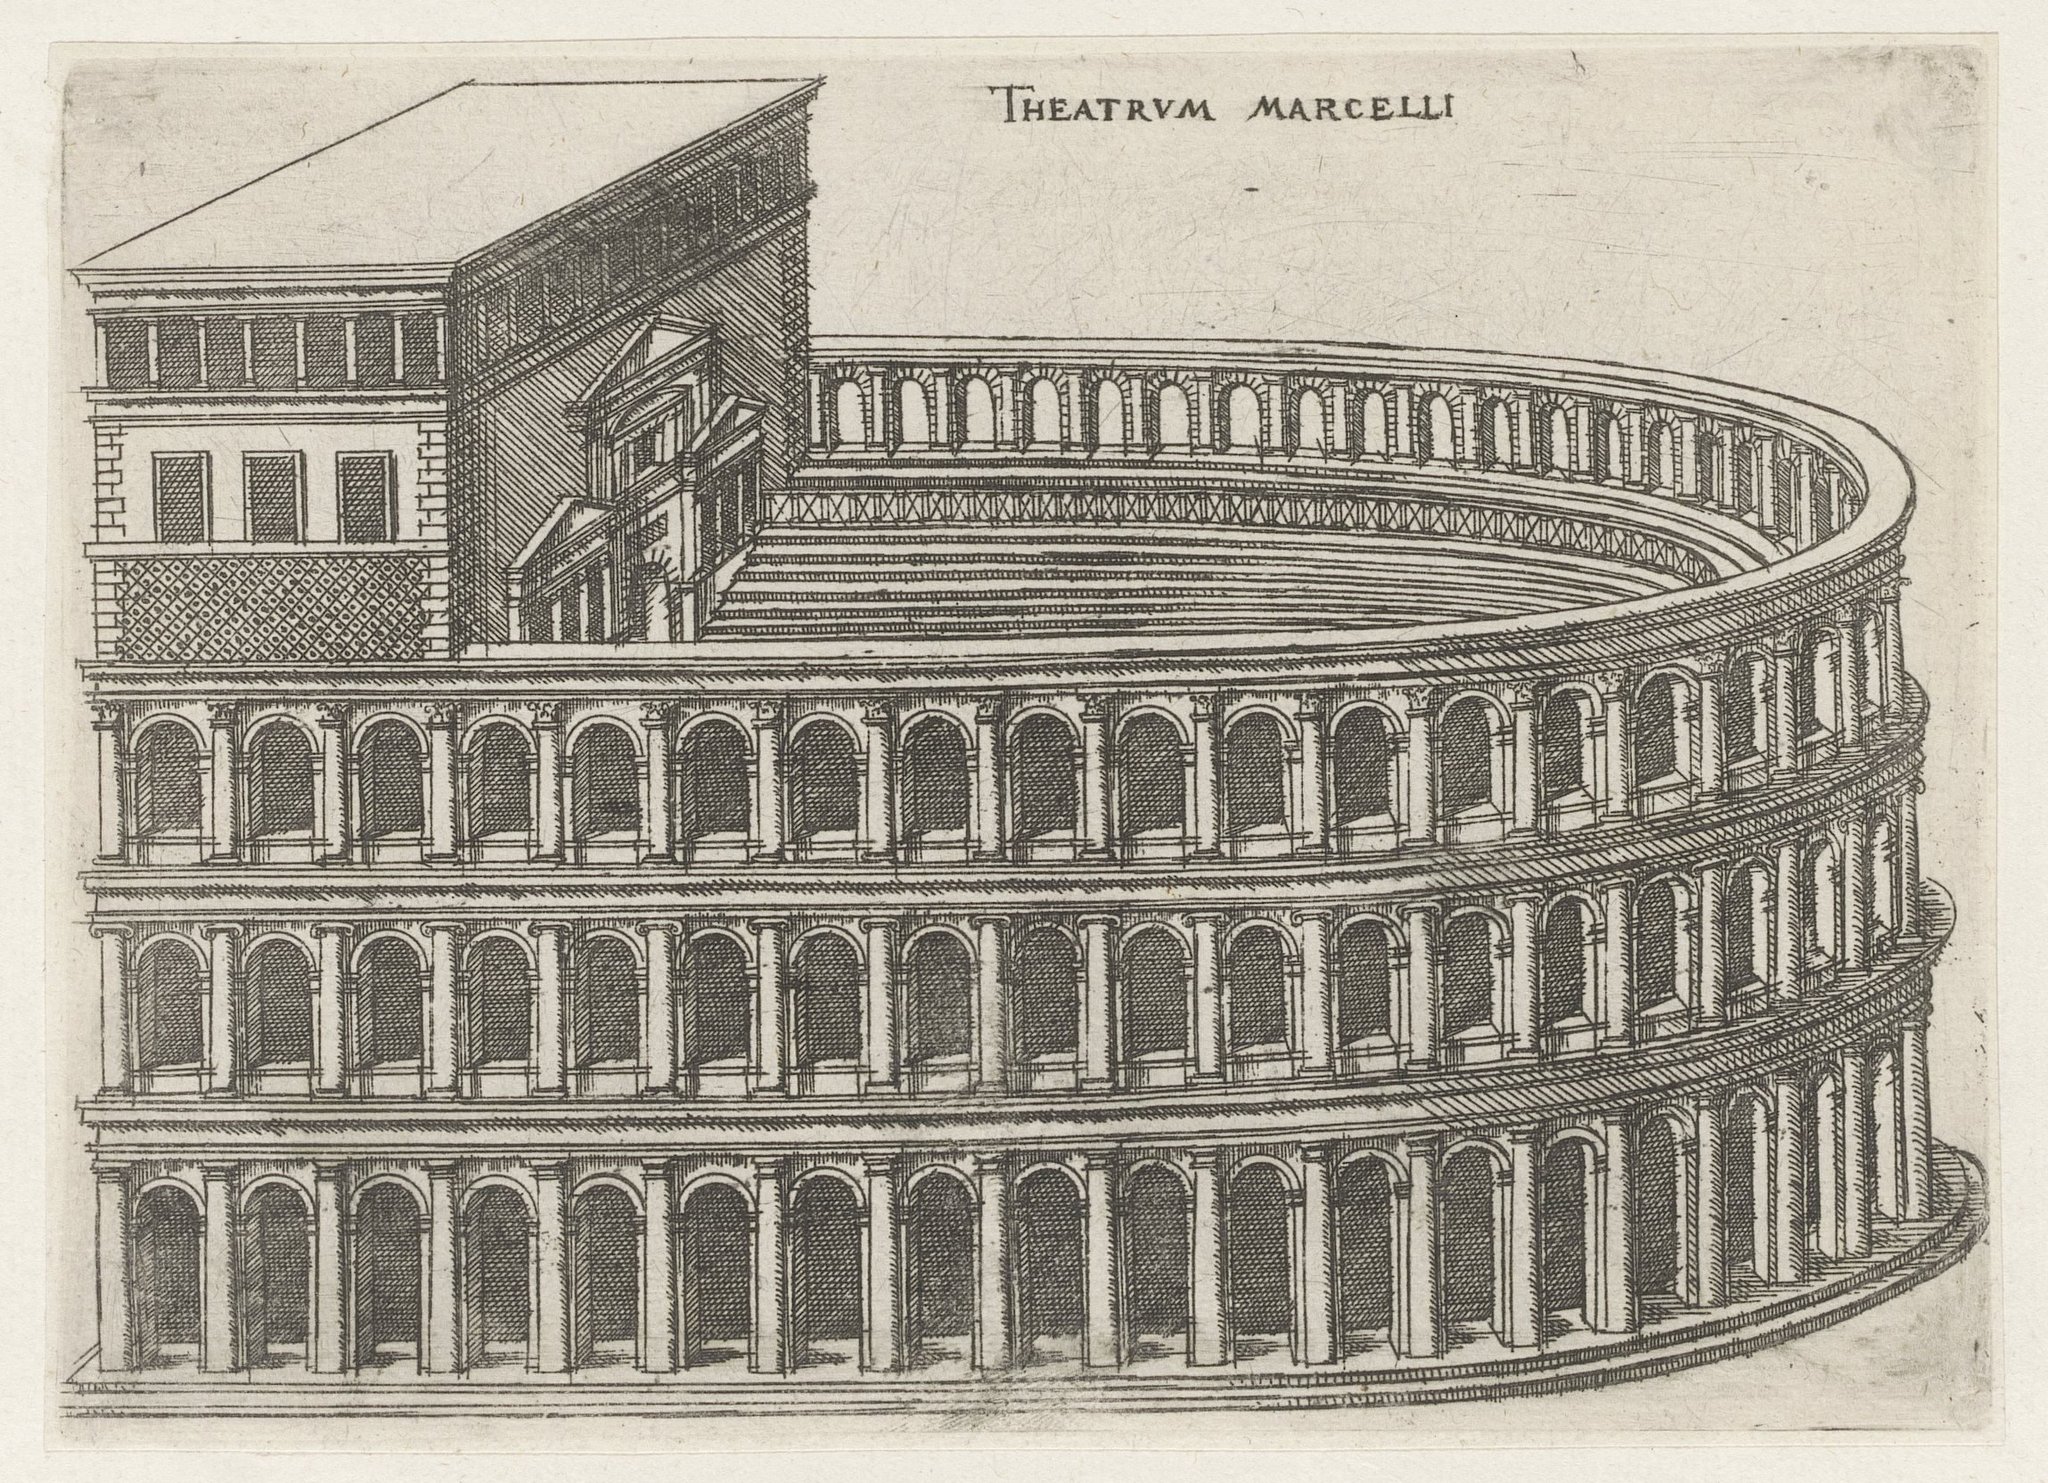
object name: print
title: Livre des edifices antiques romains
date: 1584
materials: paper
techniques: etching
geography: france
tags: theatre (building) - aa - open-air performances, representation of real building (either existing or having existed)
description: Deze prent maakt deel uit van een serie van 98 prenten gedrukt op 48 bladen. De bladen zijn verknipt en een selectie van de losse prenten is in dit album geplakt.